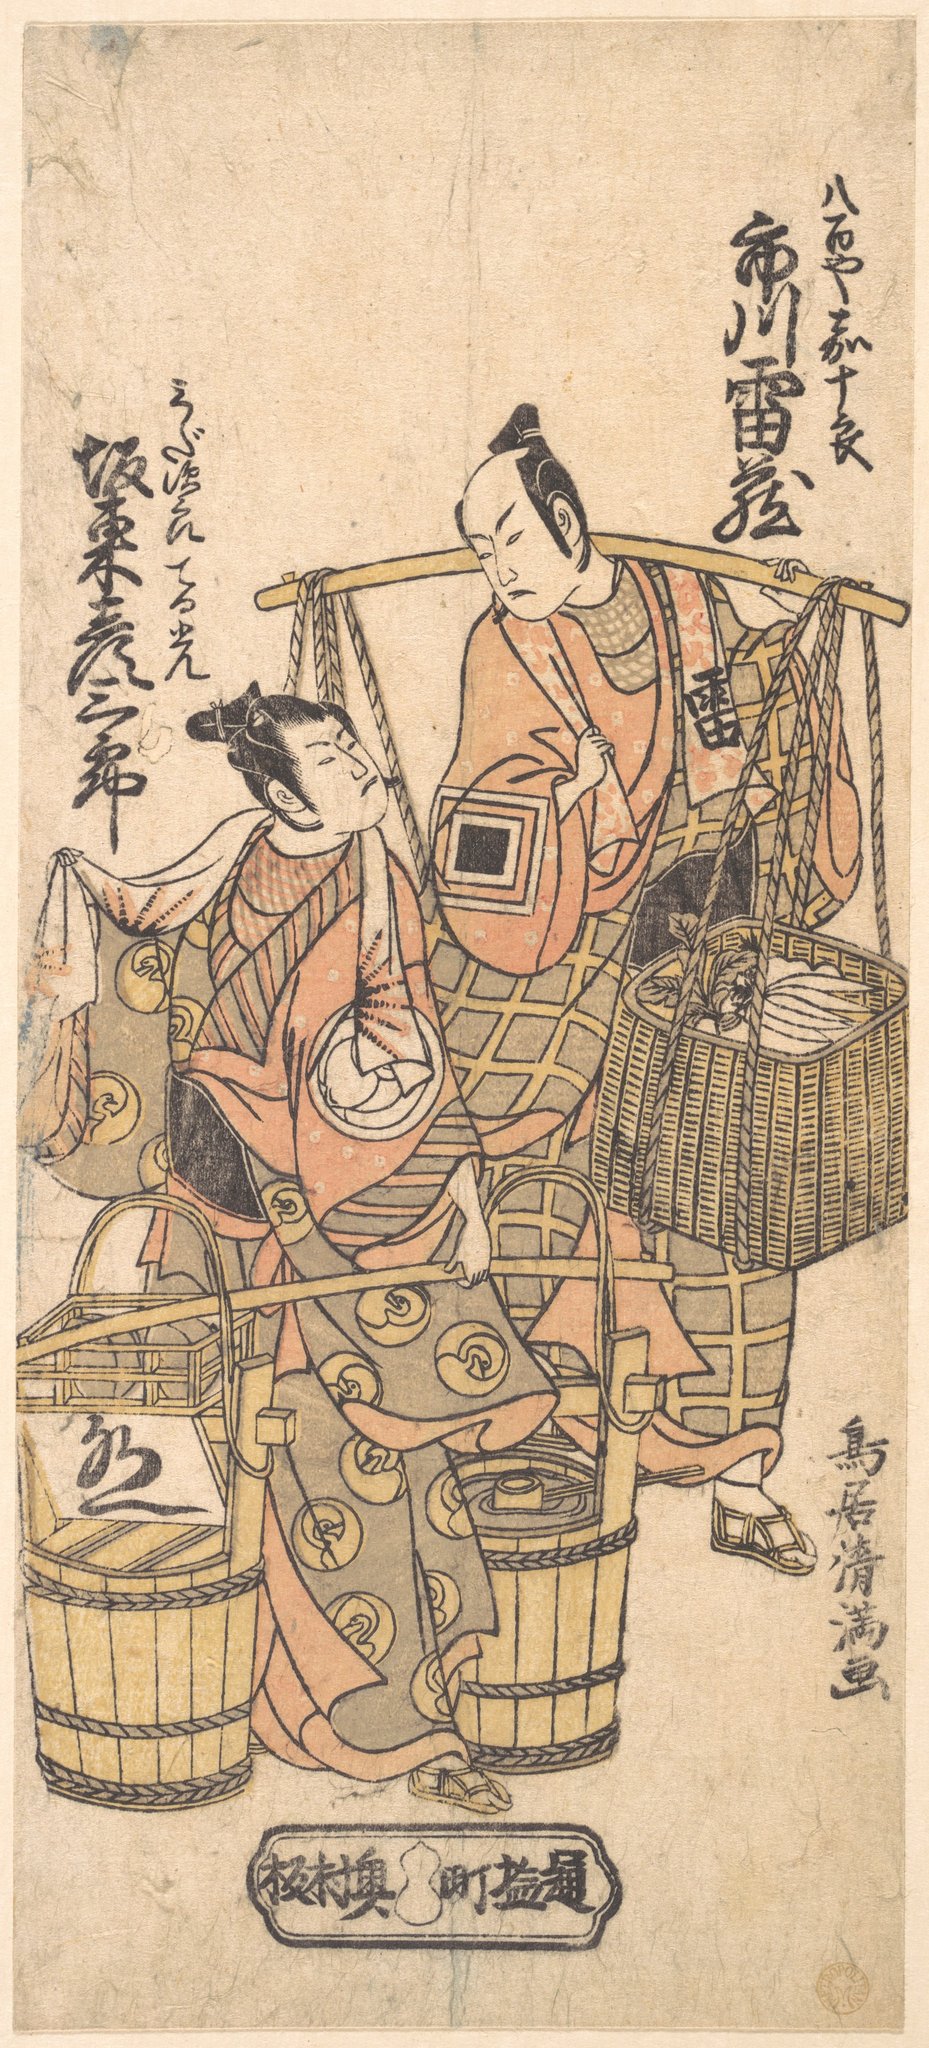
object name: woodblock print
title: Kabuki Actors Ichikawa Raizō I and Bandō Hikosaburō II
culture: japanese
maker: torii kiyomitsu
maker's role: artist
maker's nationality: japanese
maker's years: 1735-1785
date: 1767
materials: ink, paper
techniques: woodblock print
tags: men,actors,baskets,buckets